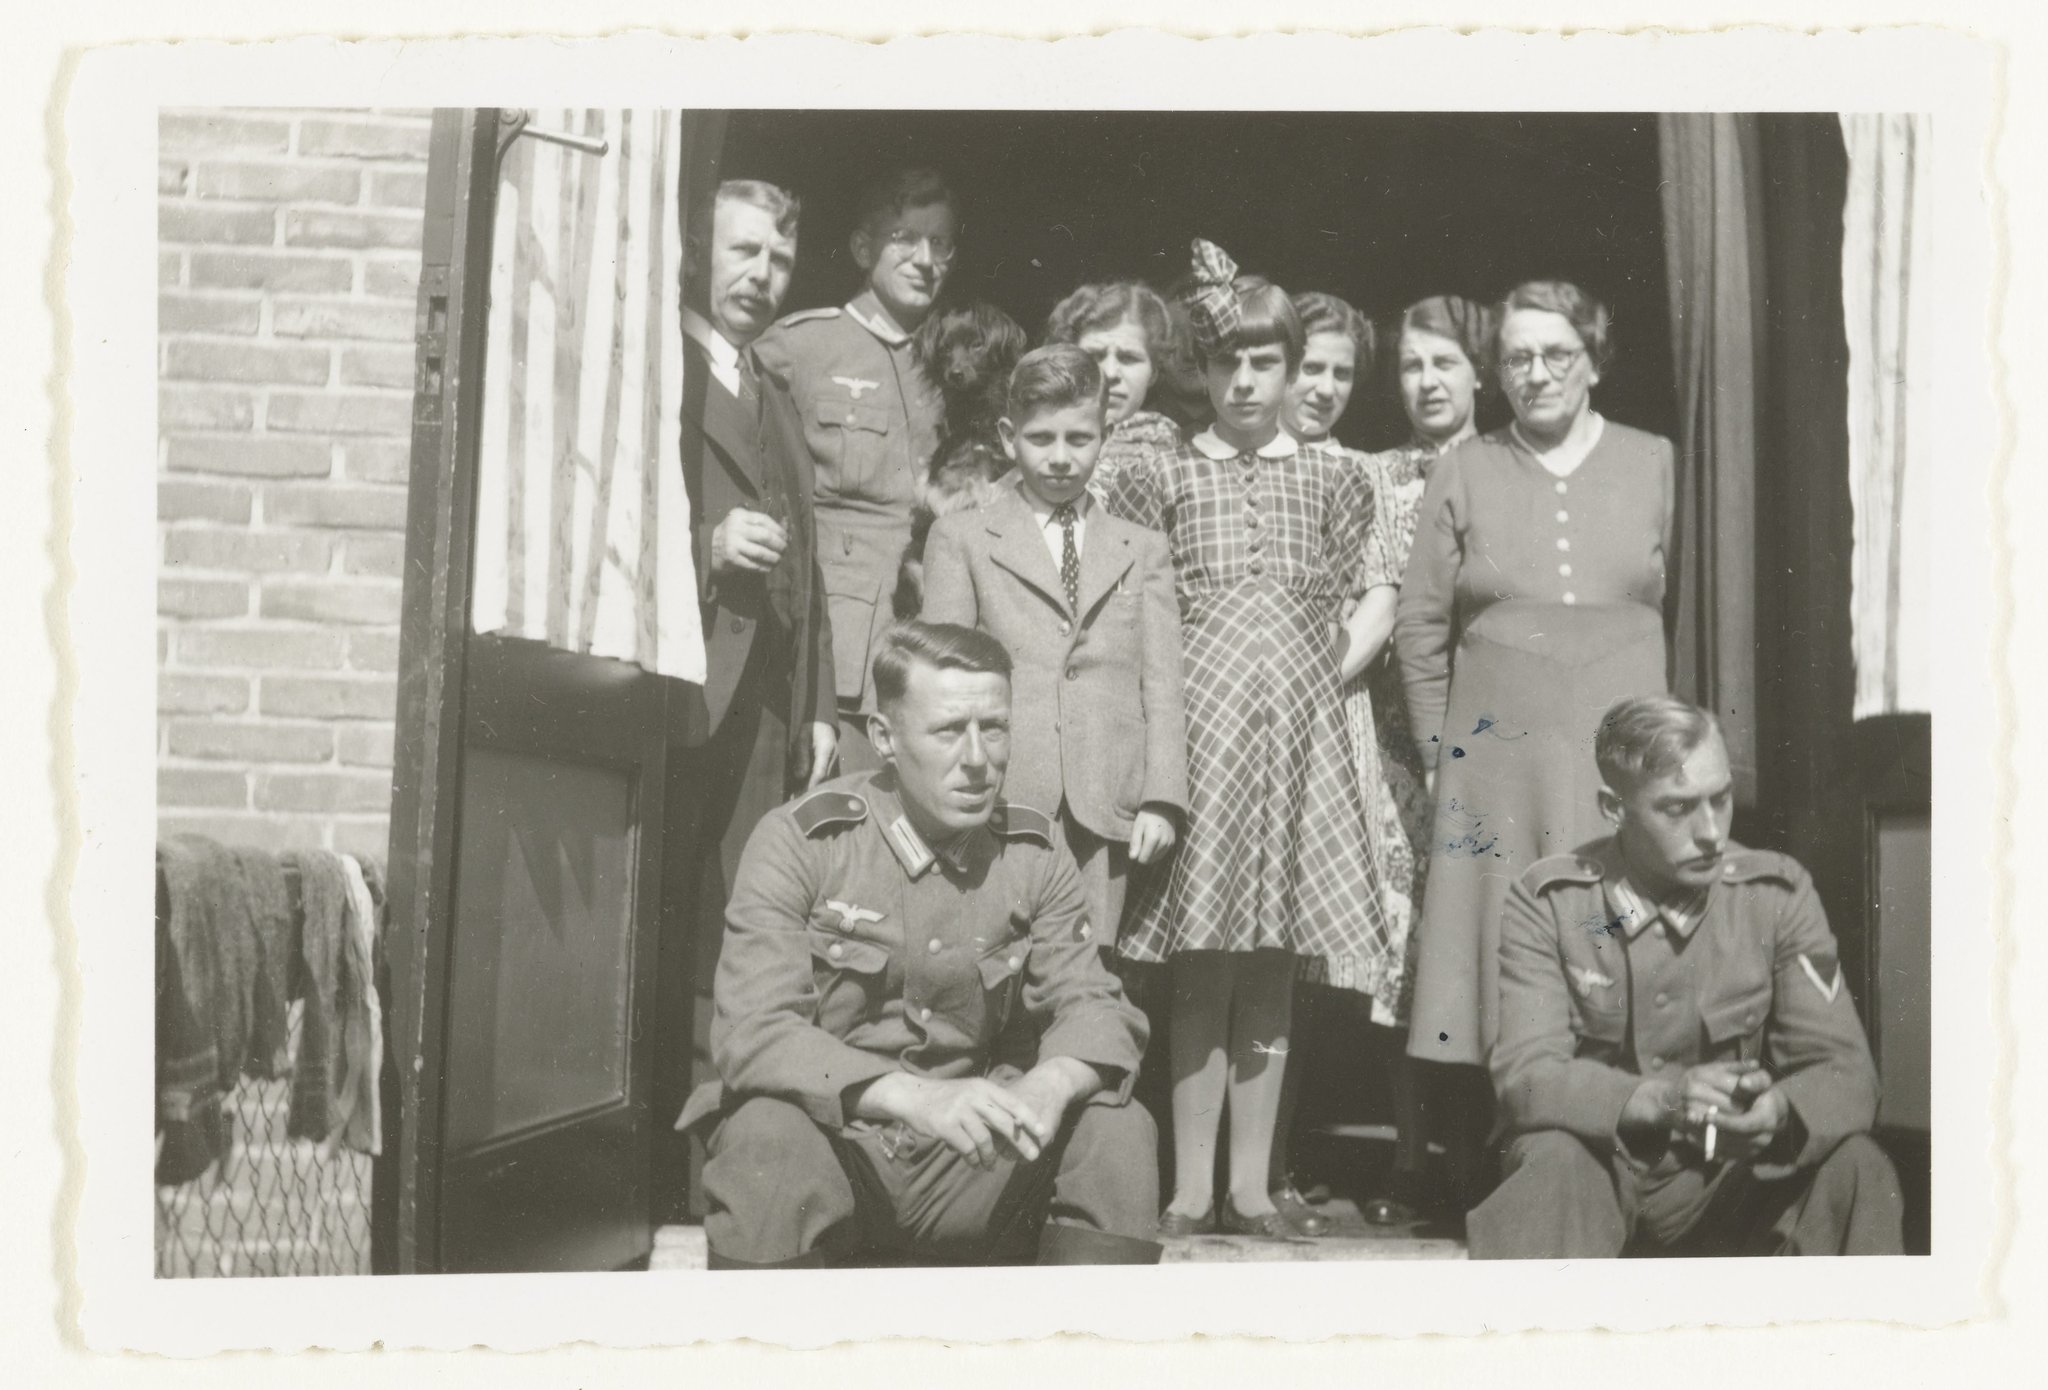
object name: photograph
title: Wehrmachtsoldaten met Nederlandse familie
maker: Anonymous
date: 1909-1940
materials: photographic support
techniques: gelatin silver print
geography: raamsdonksveer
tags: occupier and civilians, occupation ~ war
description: Drie Duitse militairen met een Nederlandse familie, zeven mensen, staand in de deuropening. Twee militairen zitten